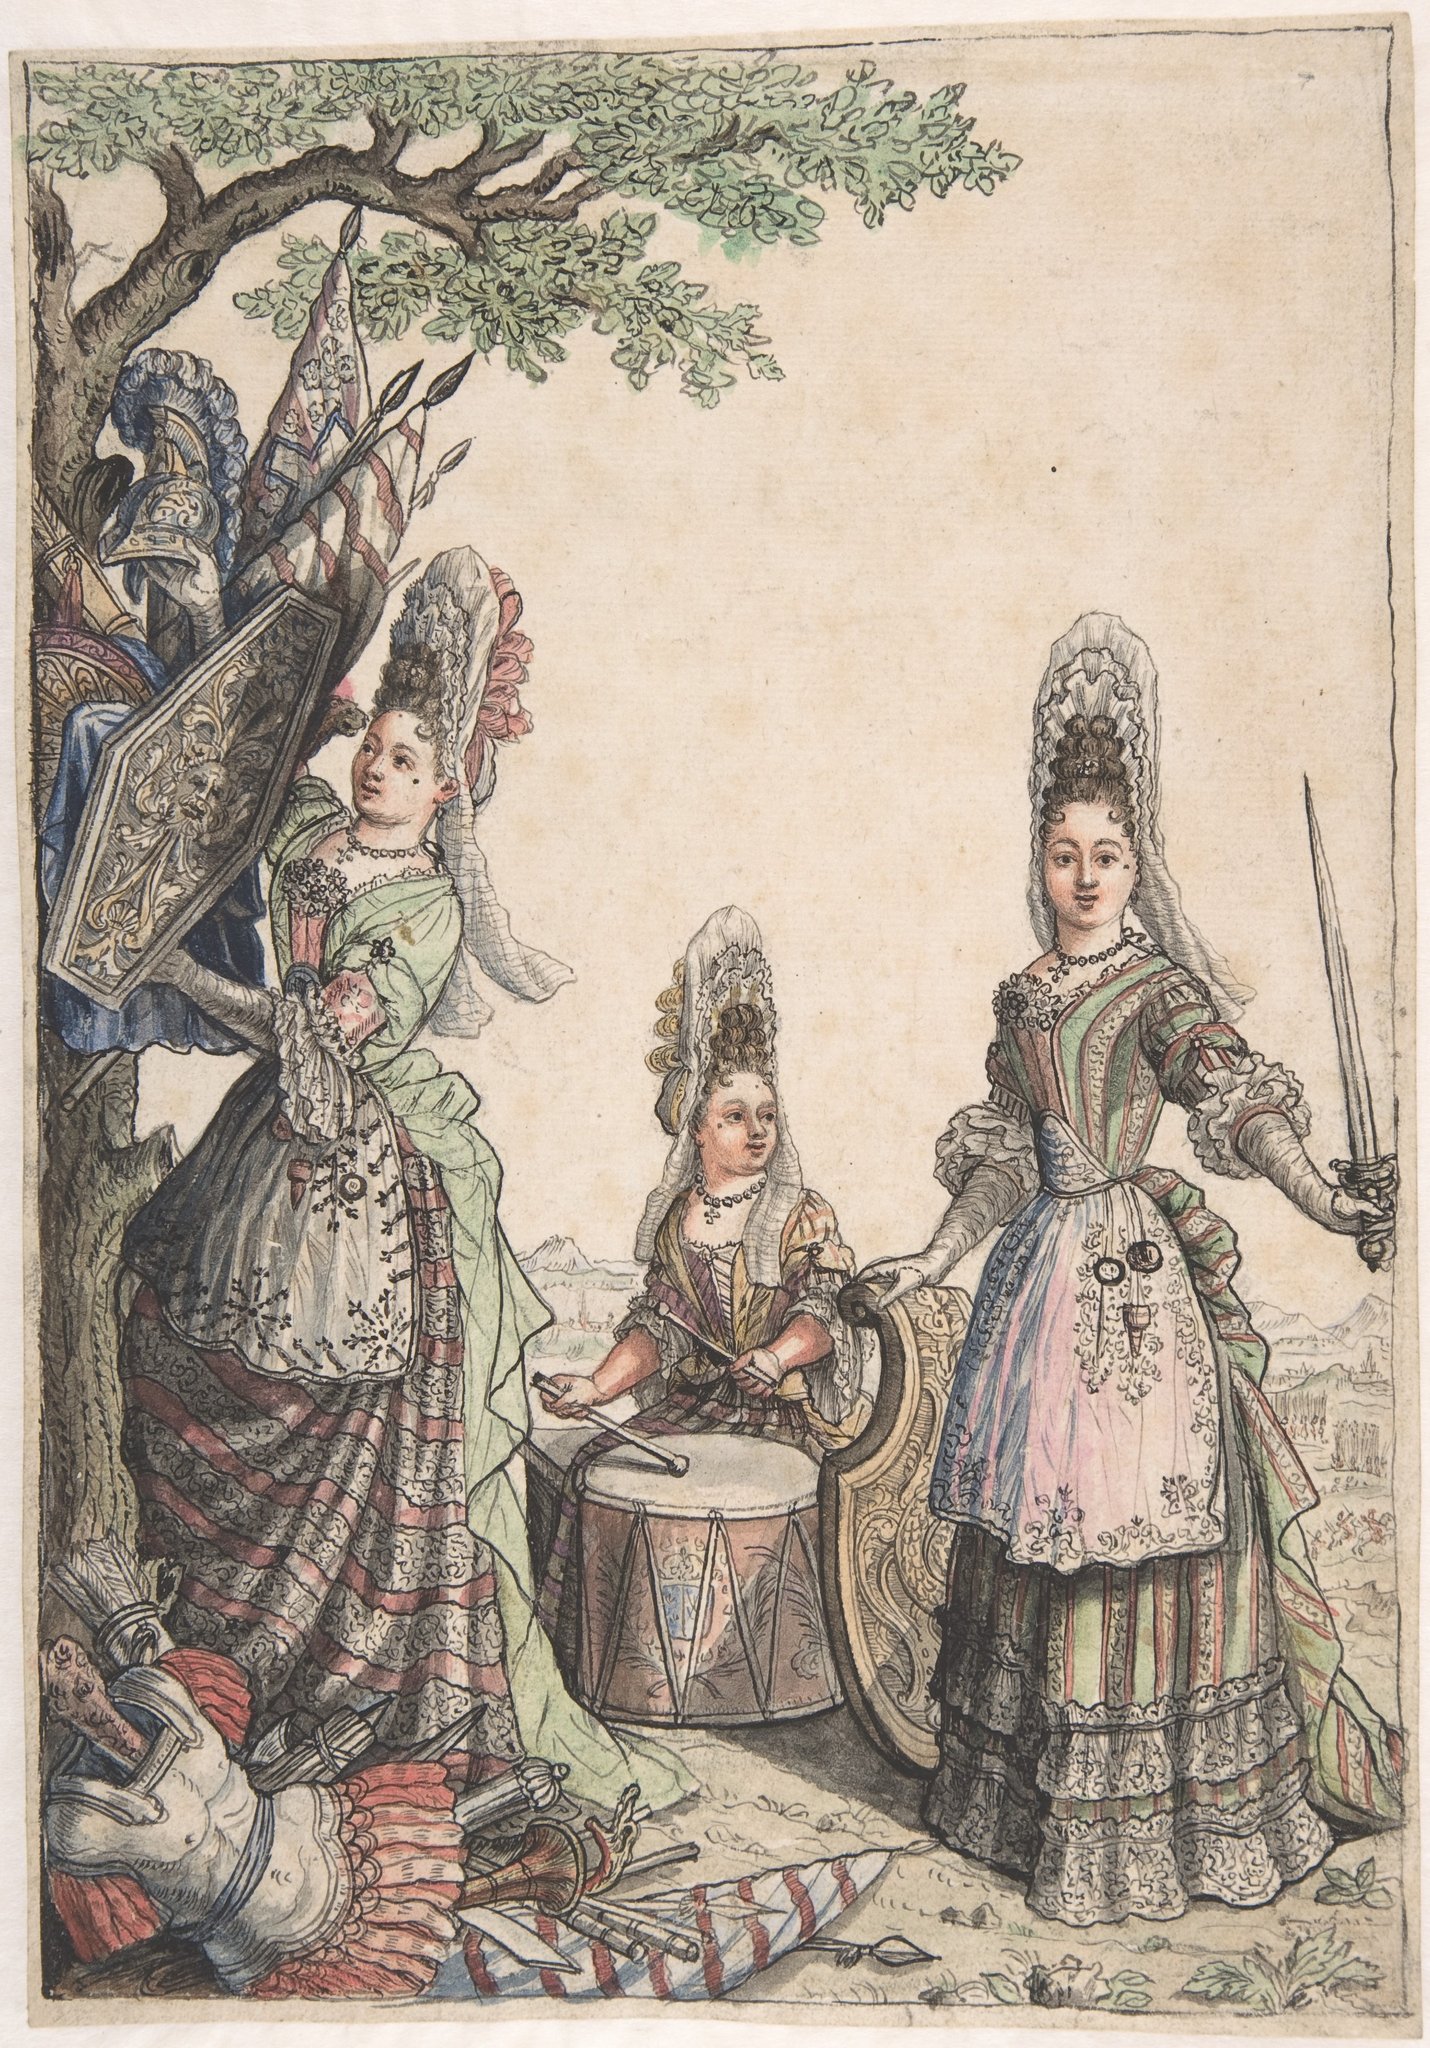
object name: drawing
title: The Iron Age (L'Age de fer)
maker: nicolas arnoult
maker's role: artist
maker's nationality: french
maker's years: 1650-1722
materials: ink, watercolor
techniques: pen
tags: shields,swords,women,drums,trees